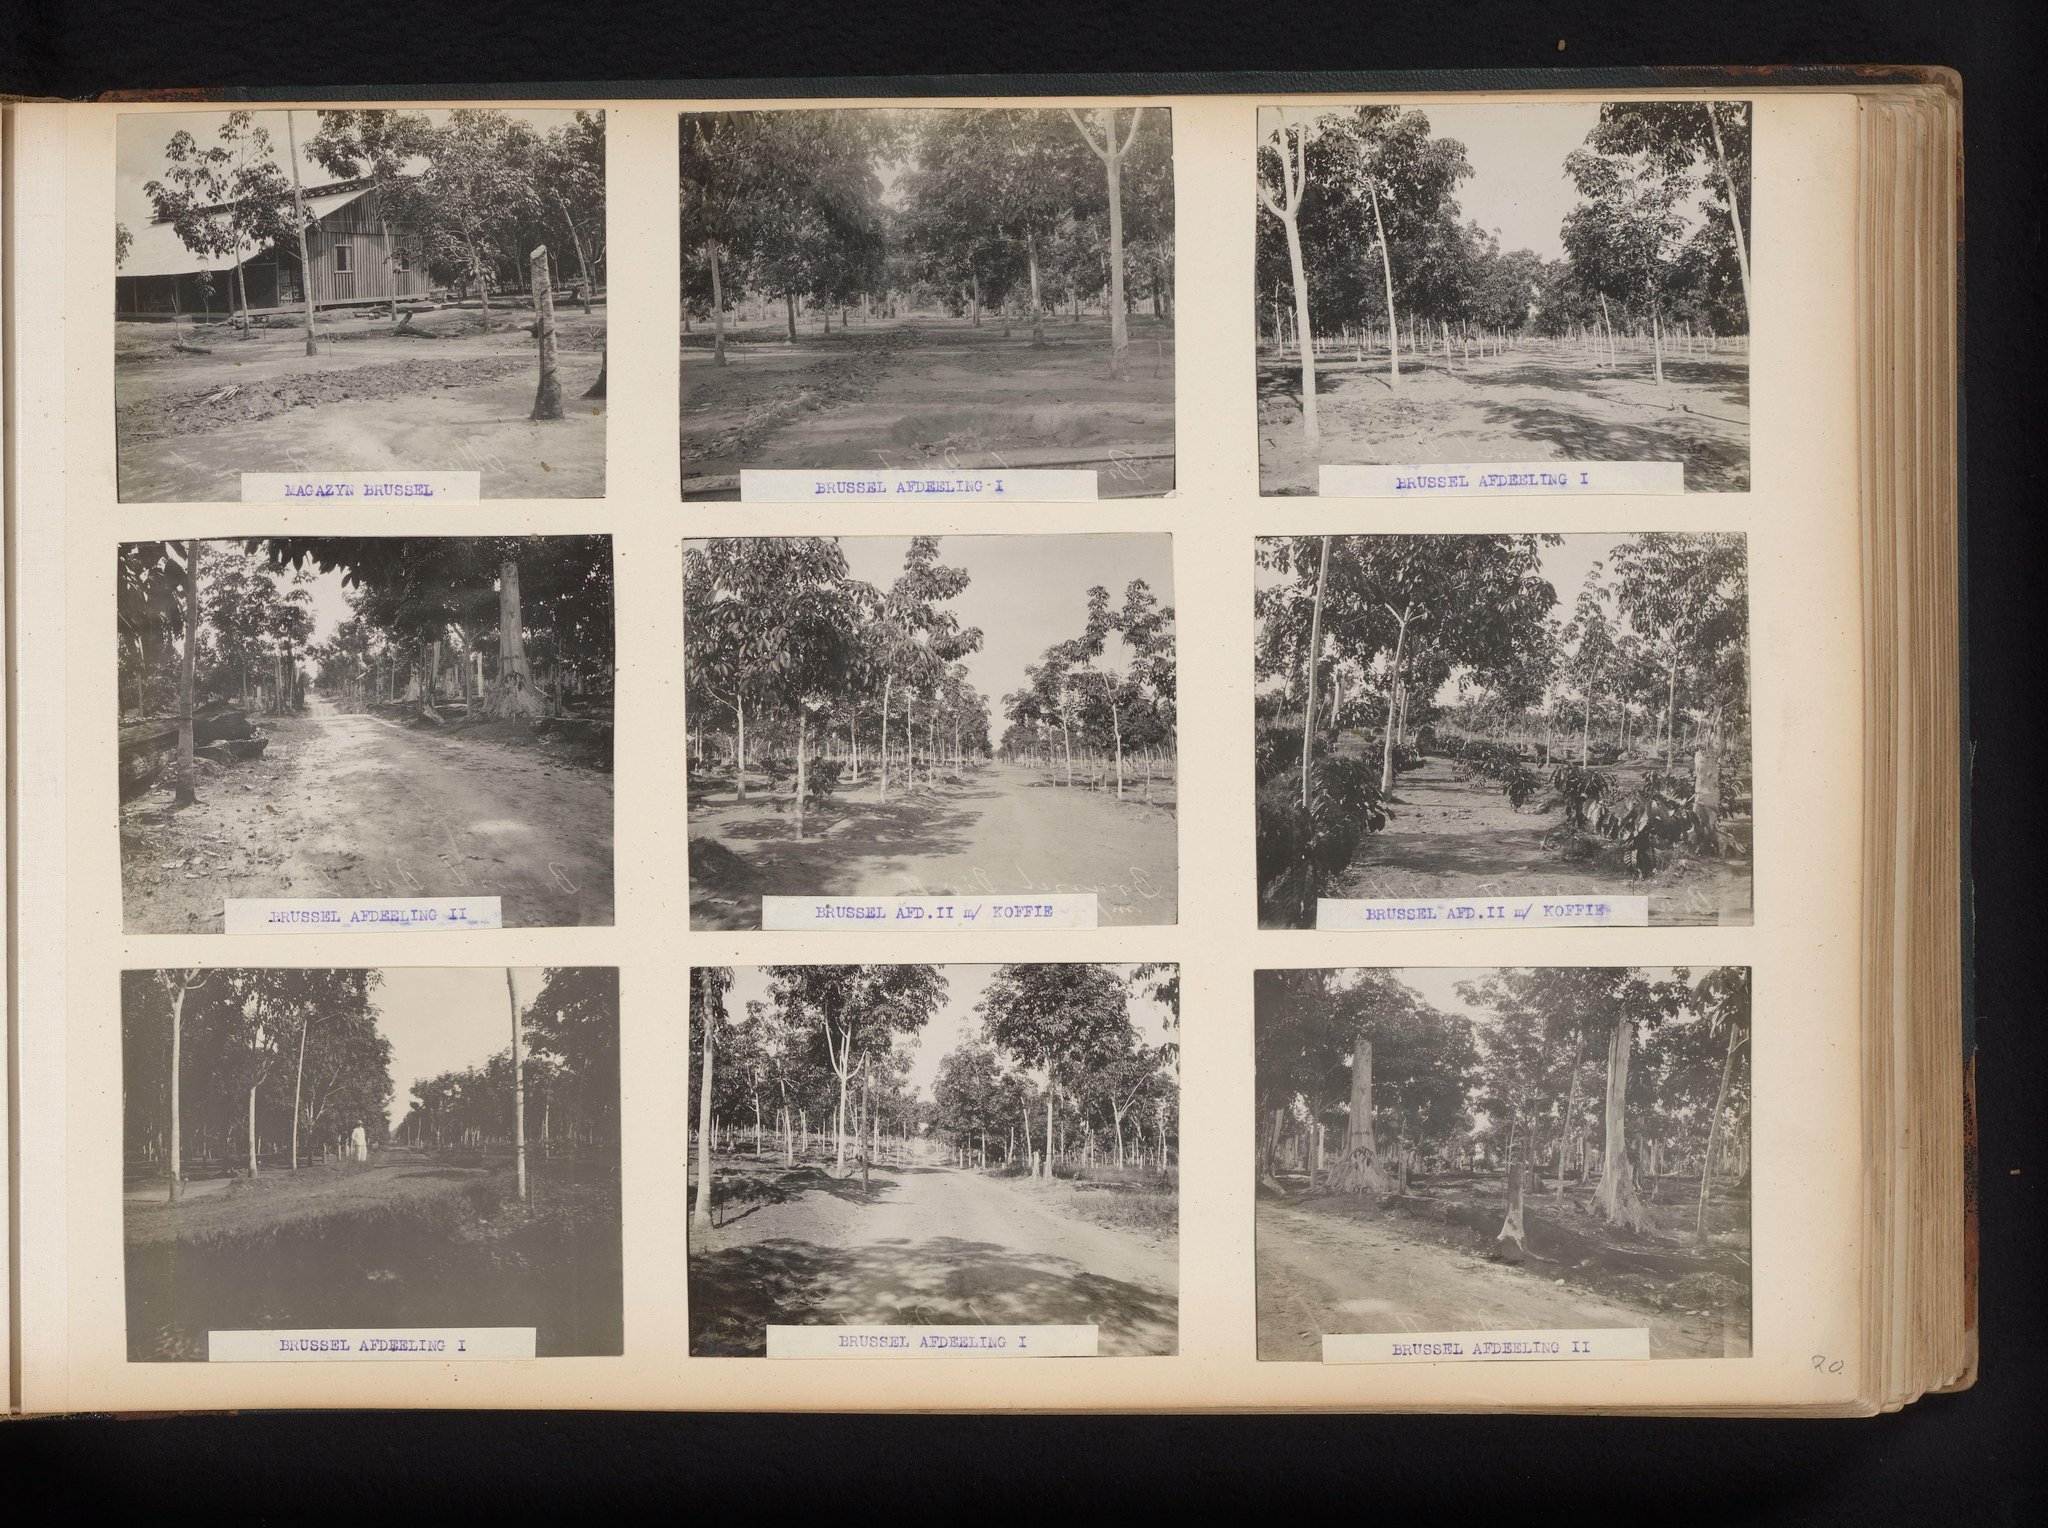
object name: album leaf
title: Rubberbomen en koffie op Brussel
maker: Anonymous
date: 1913-1915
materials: cardboard, photographic support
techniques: gelatin silver print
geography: east sumatra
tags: plantation, (non-fruit) products of plants or trees: rubber, fruits: coffee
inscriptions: inscription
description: Blad met negen foto's van rubberbomen en koffieplanten op plantage Brussel. Onder de foto's etiketten met onderschriften. Onderdeel van het fotoalbum over de plantages Brussel en Pernantian van de Sumatra Caoutchouc Maatschappij op de Oostkust van Sumatra in de jaren 1910-1935.